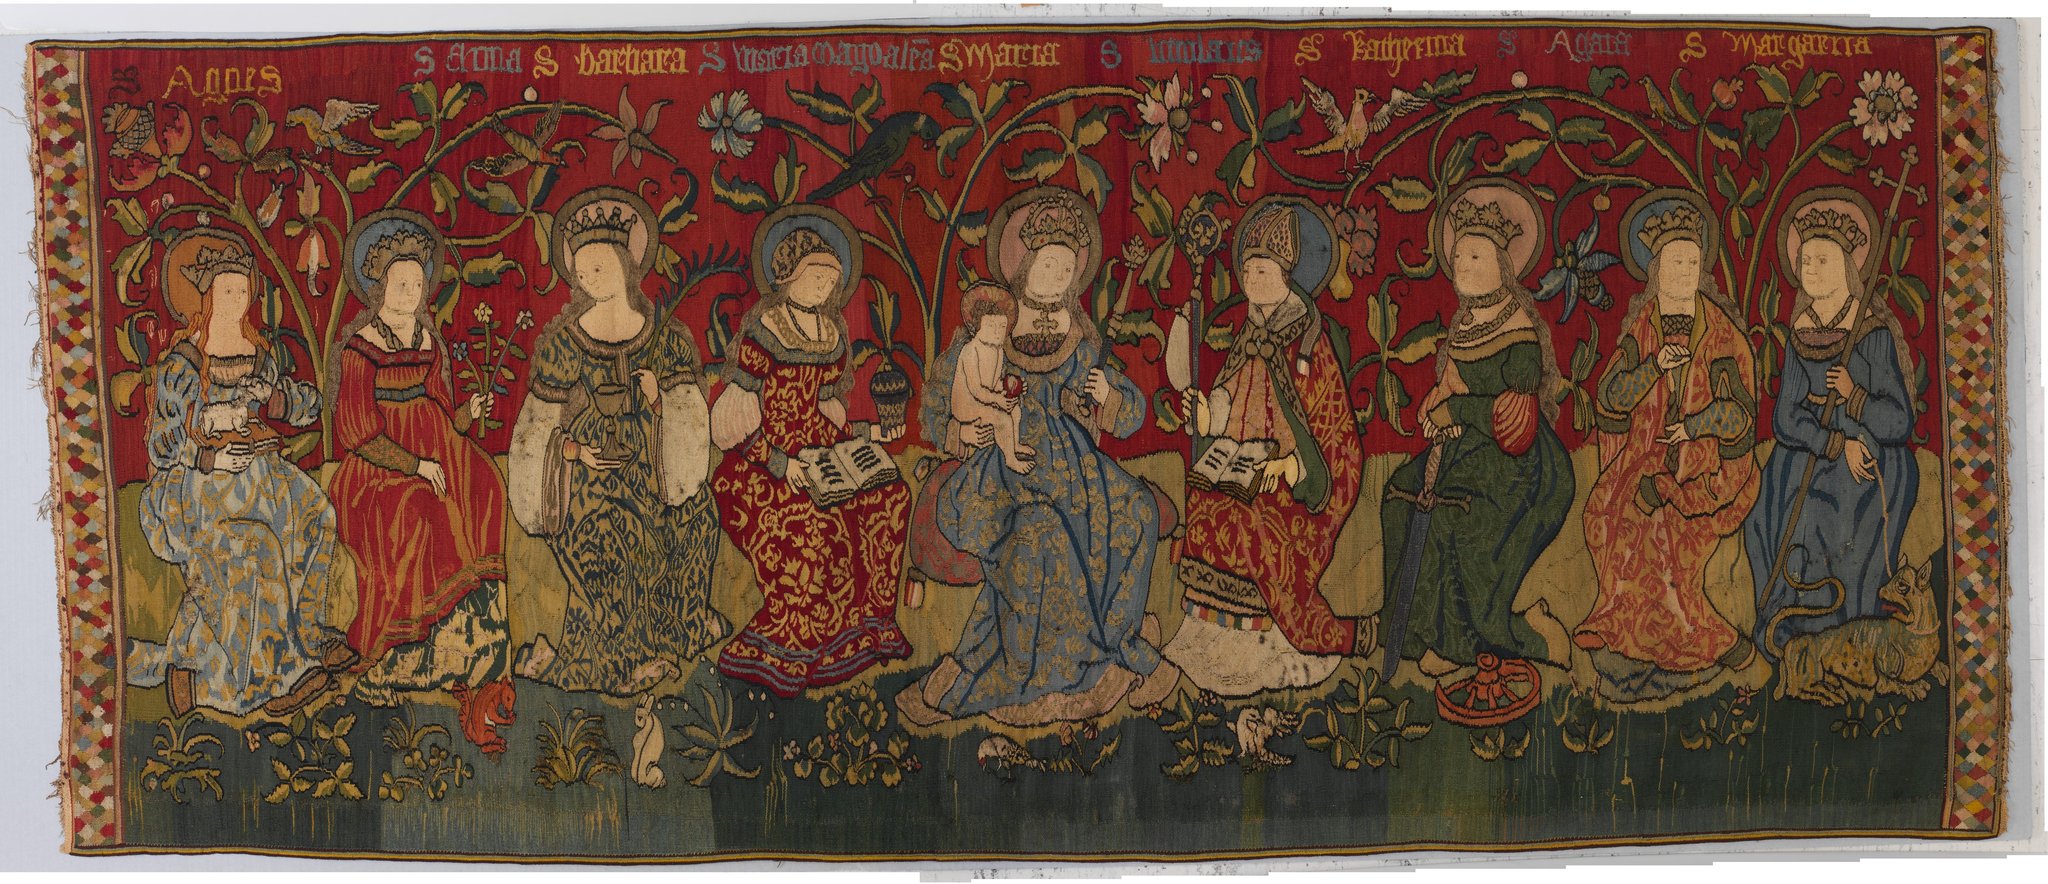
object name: antependium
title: Madonna with Eight Saints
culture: upper rhenish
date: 1550-1600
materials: linen, silk, wool, thread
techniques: embroidery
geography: switzerland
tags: birds,rabbits,squirrels,madonna and child,saints